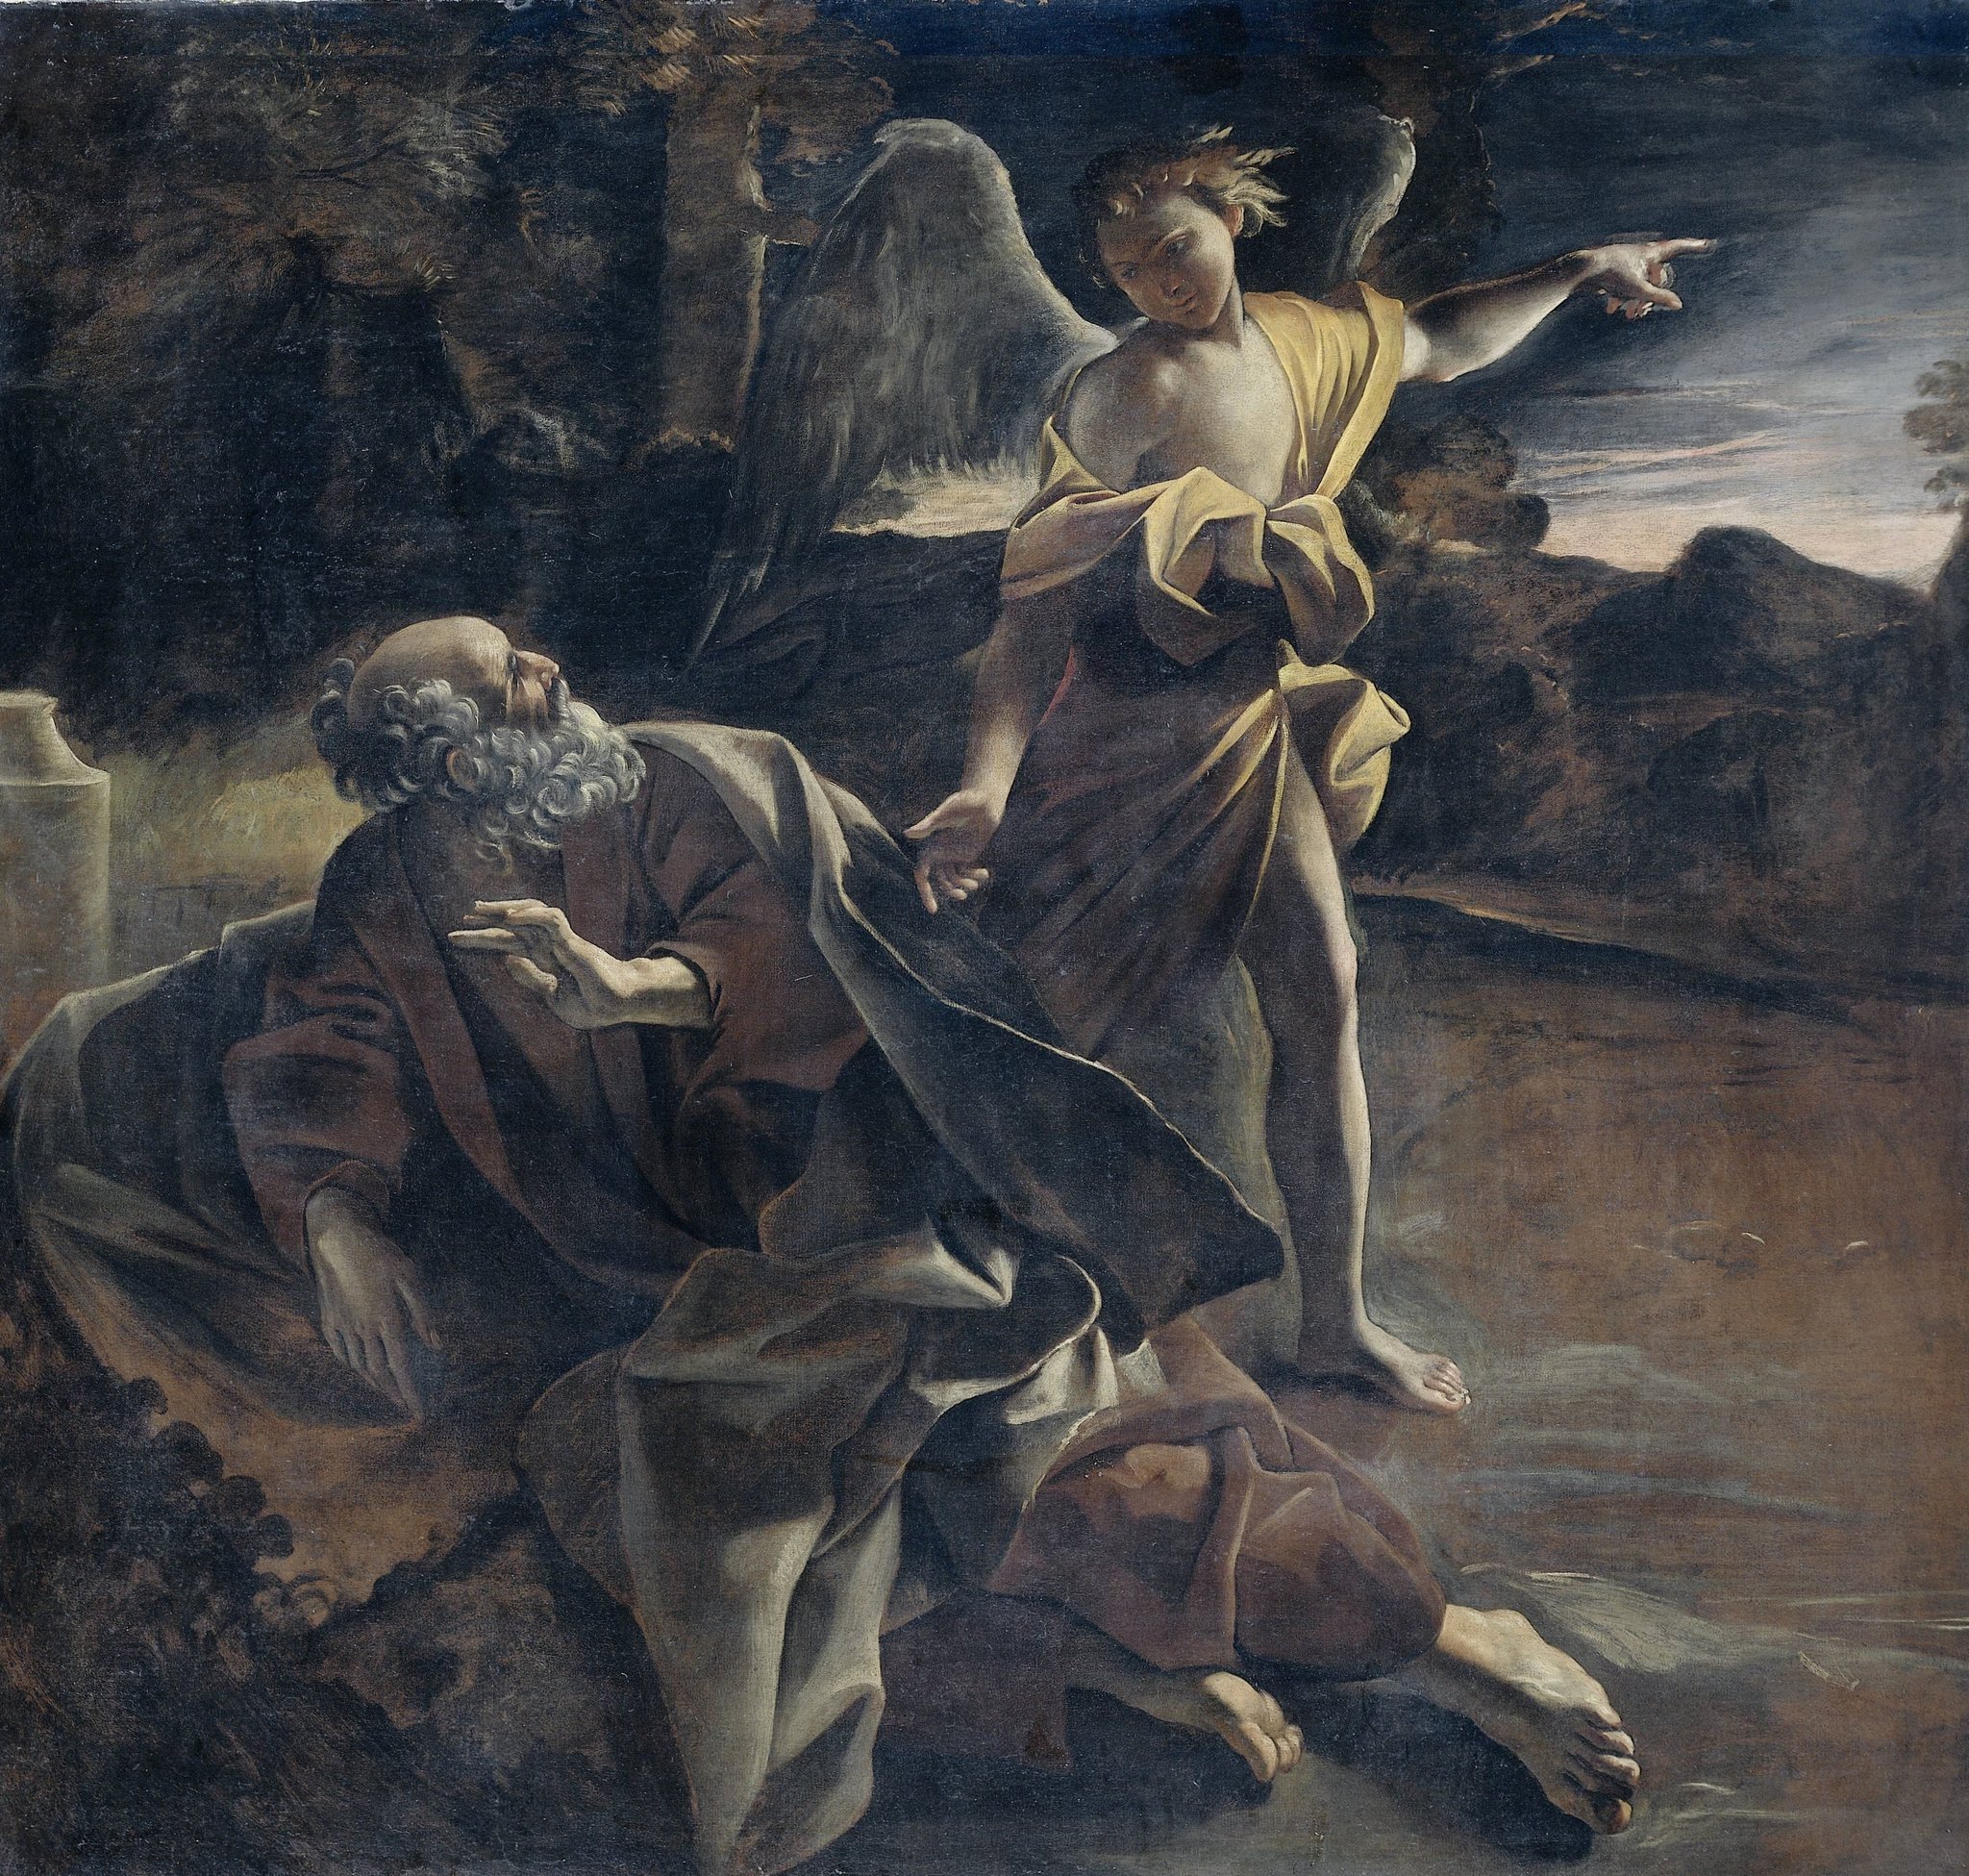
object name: painting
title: The Prophet Elijah Awakened in the Desert by an Angel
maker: giovanni lanfranco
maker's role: draughtsman, painter, print maker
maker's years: 1582-1647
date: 1624-1625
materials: canvas, oil, paint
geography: italy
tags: an angel wakes elijah; a loaf of bread and a jar of water are usually at elijah's head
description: De profeet Elia bij dageraad in de woestijn door een engel gewekt. De profeet kijkt verschrift op naar de engel die met de linkerhand naar achteren wijst. Vervaardigd in 1624-25 als deel van een reeks van acht schilderijen voor de kapel van de sacramenten in de kerk San Paolo fuori le mura te Rome.